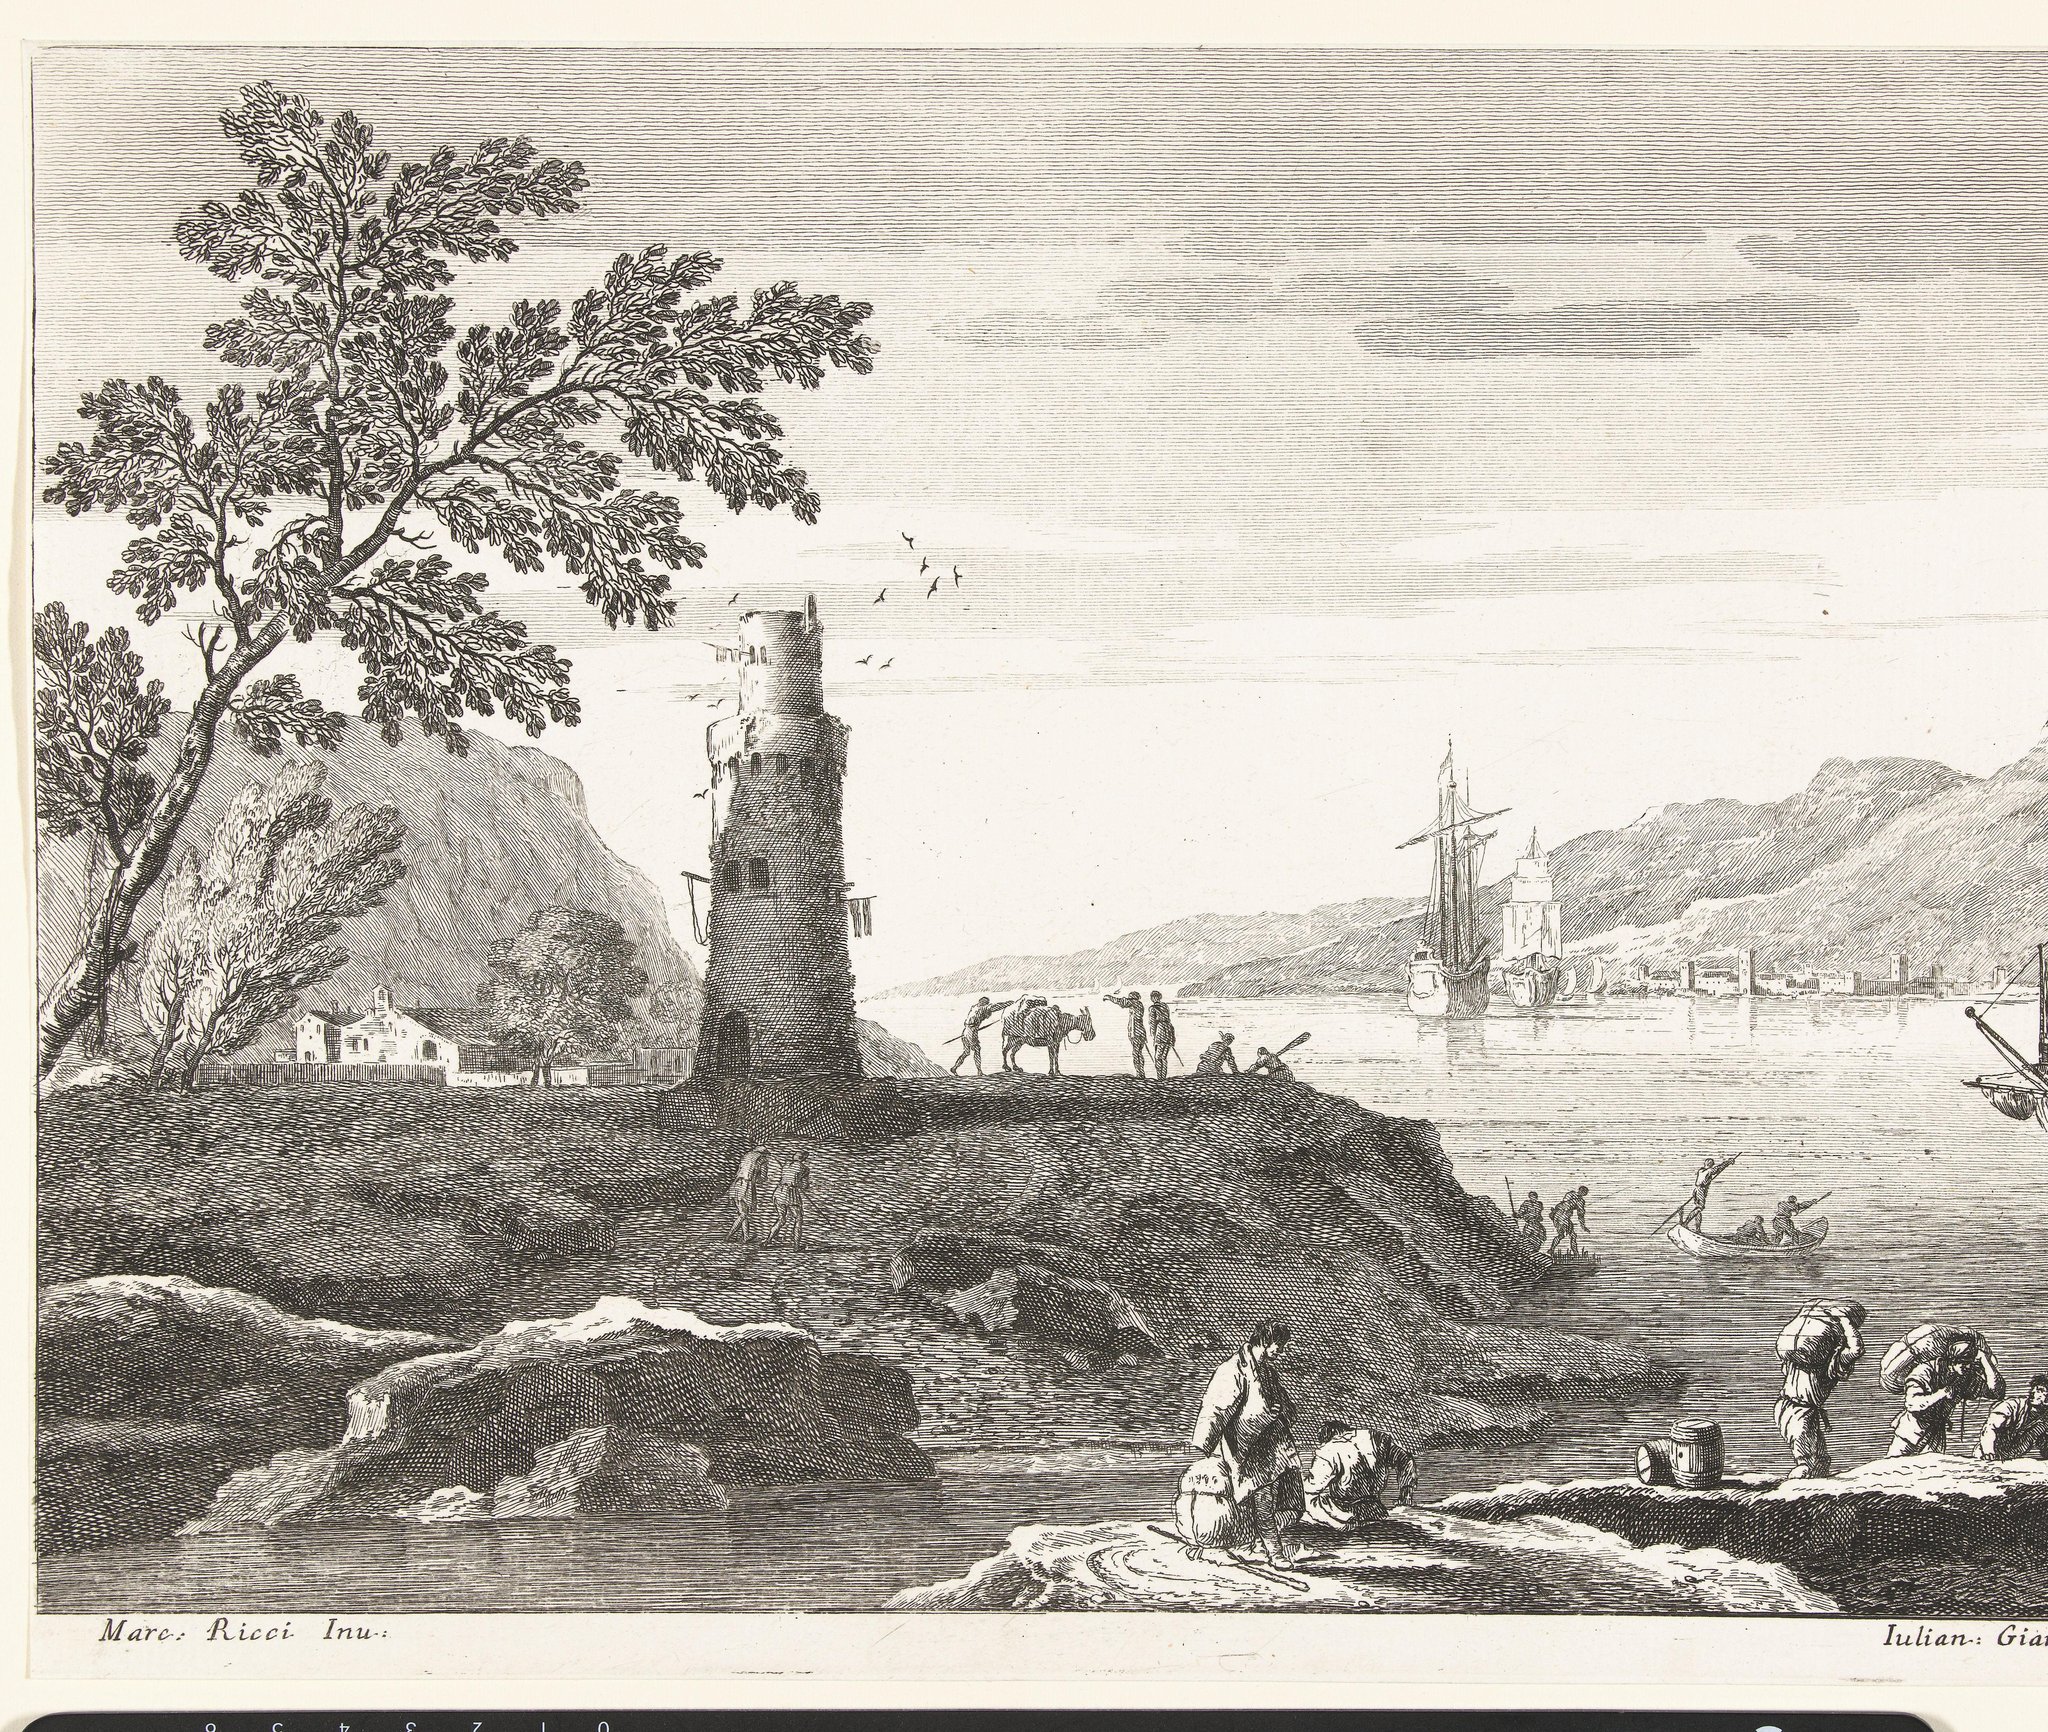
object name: print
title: Kustlandschap met vuurtoren en schepen voor anker in baai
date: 1739-1740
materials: paper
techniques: etching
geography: venice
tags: lighthouse, lightship, harbouring, coast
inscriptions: collector's mark: Lugt 2228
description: Prent uit eerste serie van achttien prenten met Italiaanse landschappen naar ontwerp van Marco Ricci en titelprent (zie RP-P-1952-20) opgedragen aan consul Joseph Smith.